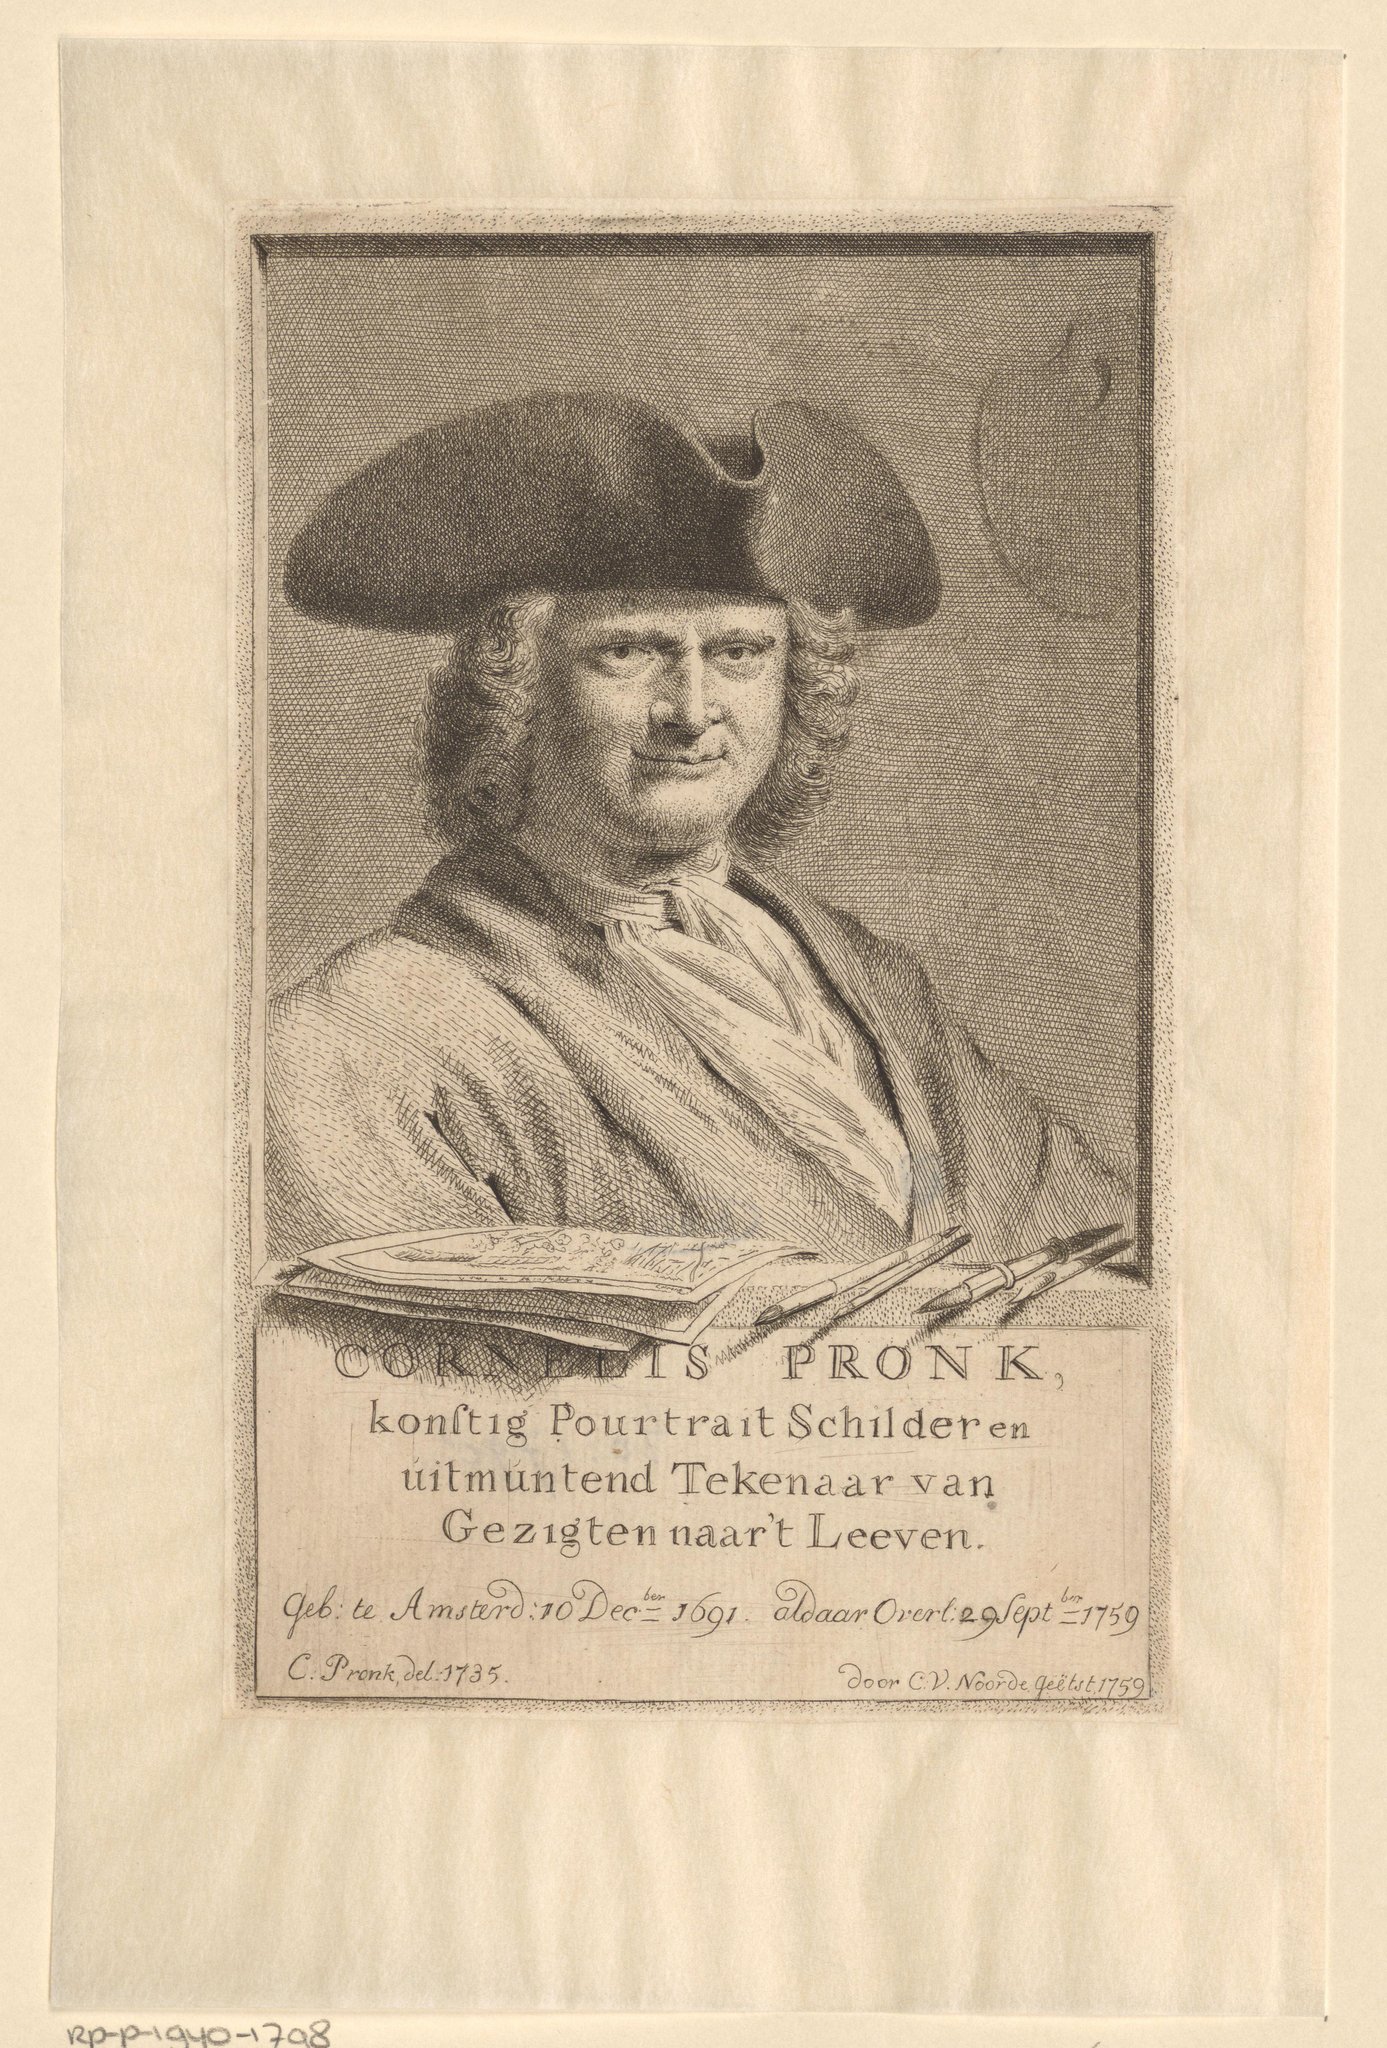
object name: print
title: Portret van Cornelis Pronk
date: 1759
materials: paper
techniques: etching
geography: haarlem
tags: amsterdam, painter, draughtsman, cornelis pronk, historical persons, tools, implements of painter, portrait, self-portrait of artist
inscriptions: collector's mark: Lugt 2228, collector's mark: Lugt 2760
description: Met vierregelig onderschrift in het Nederlands.